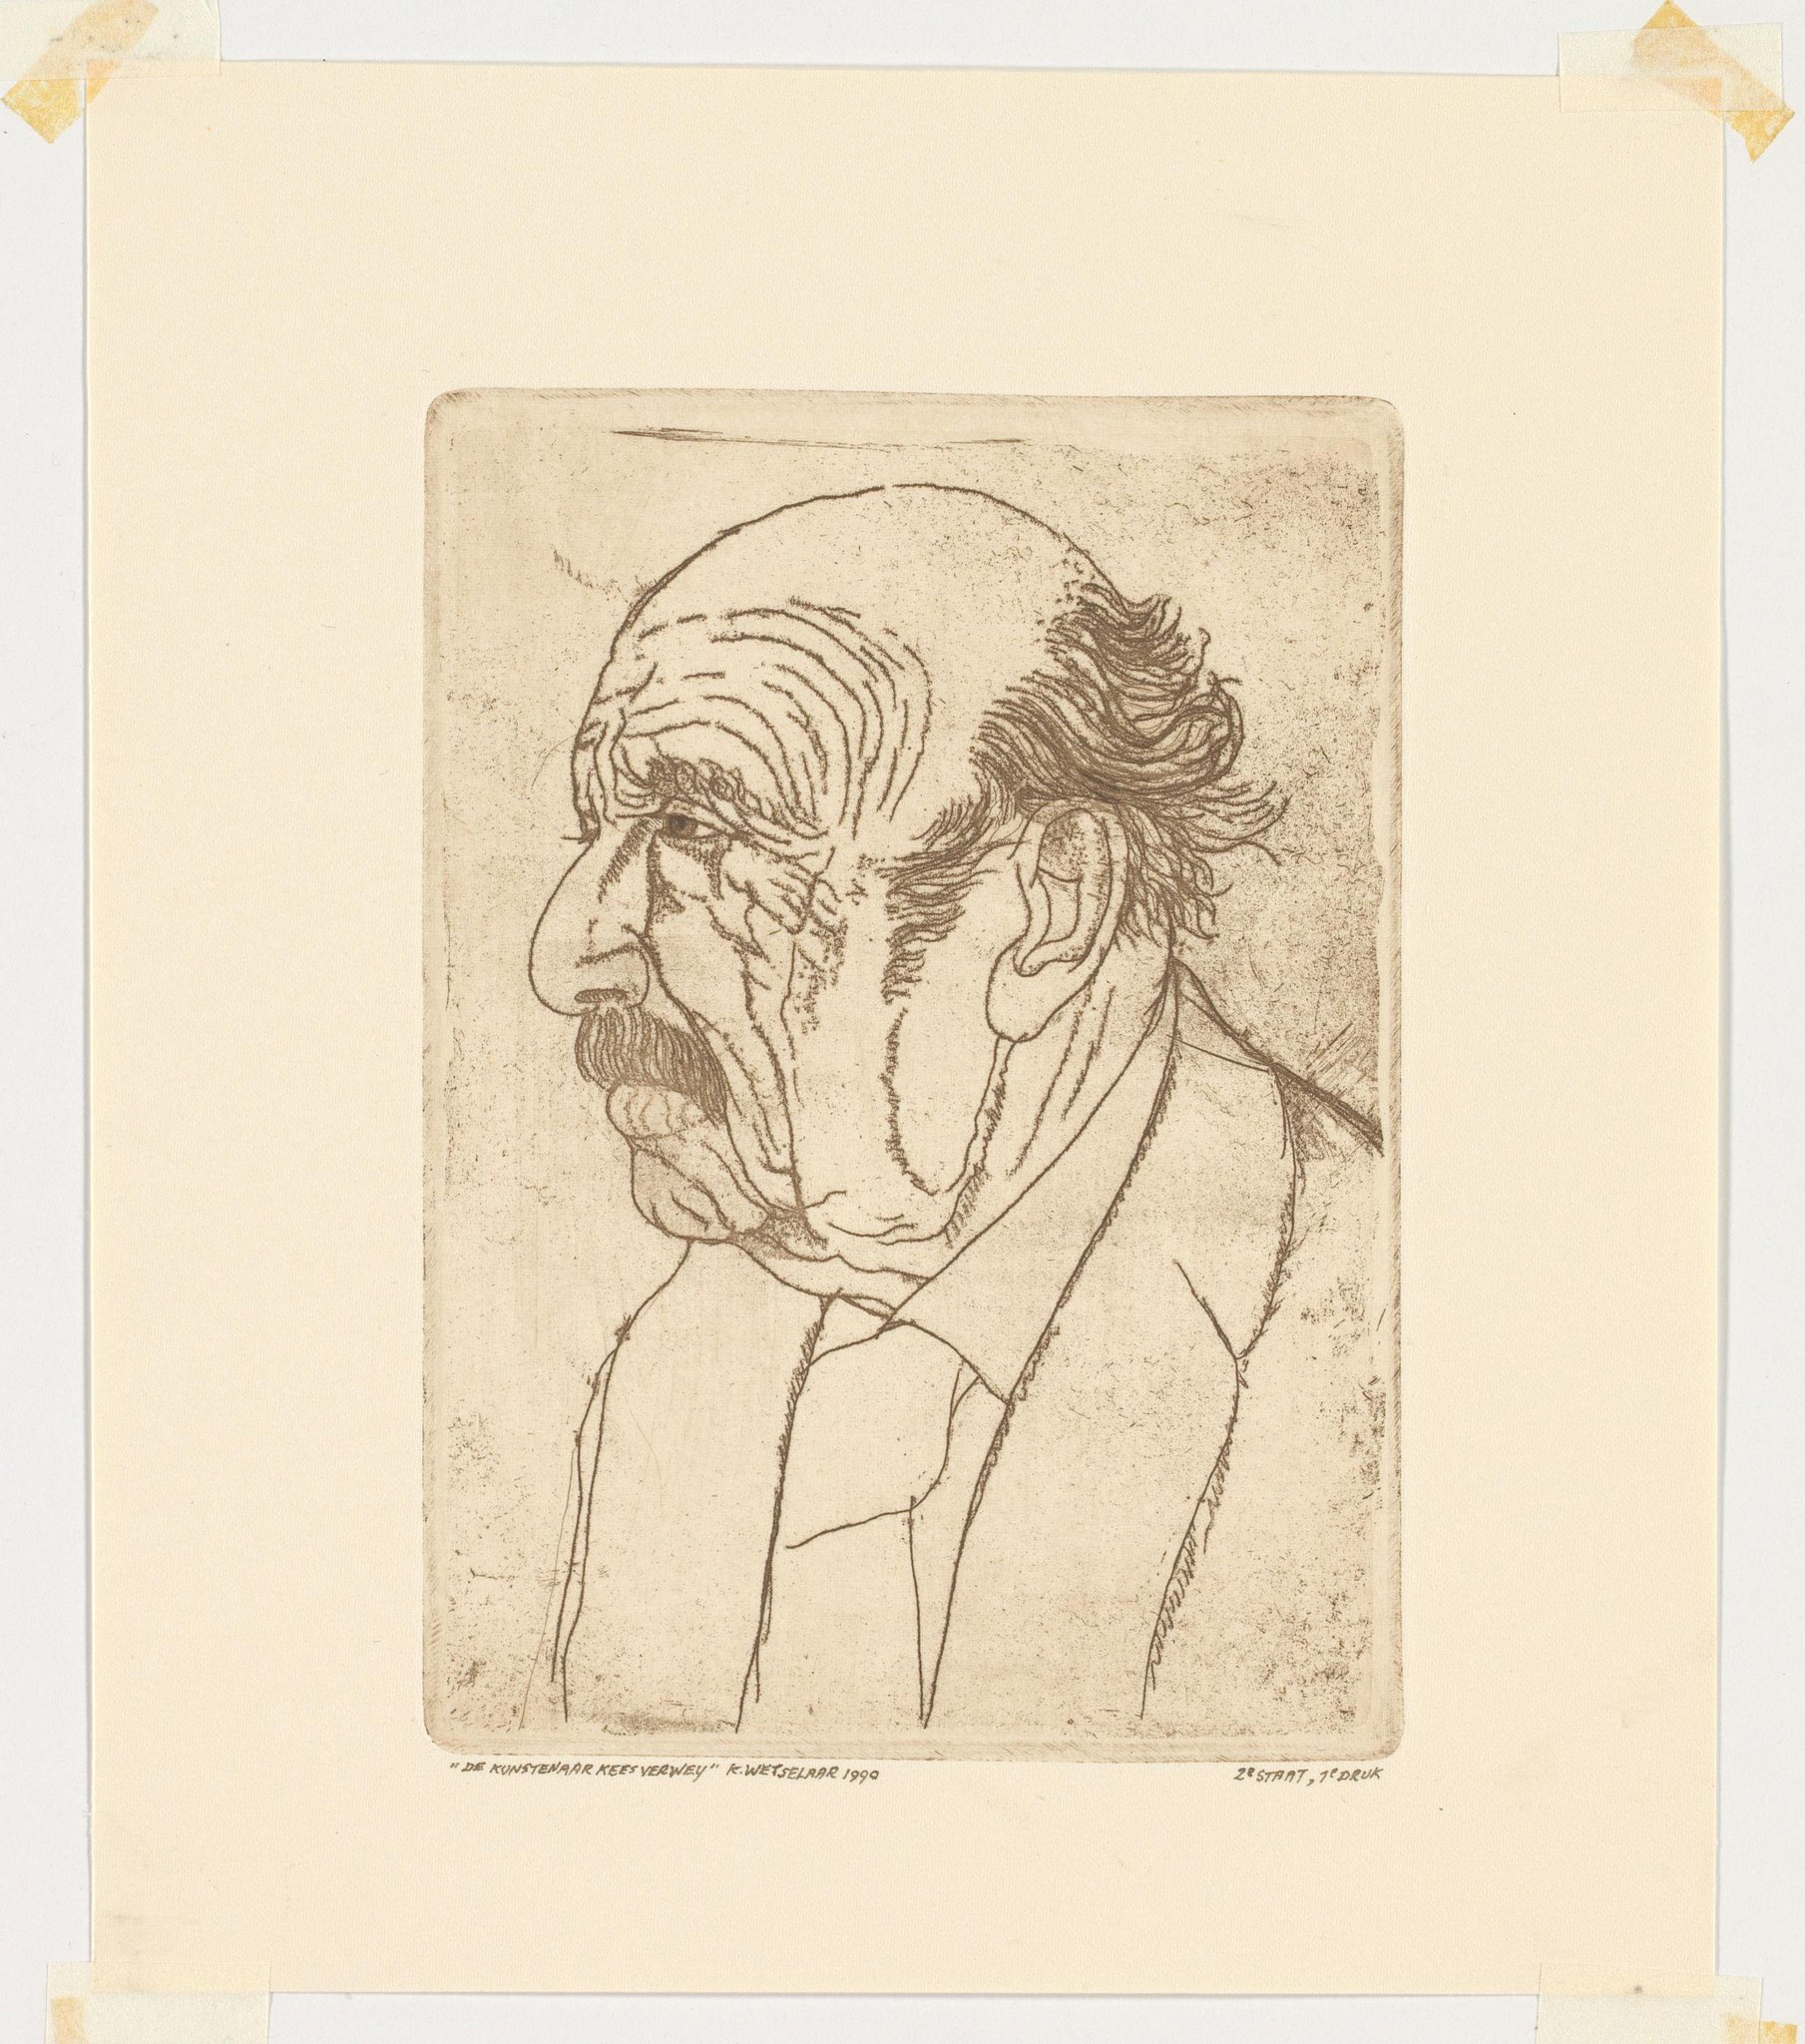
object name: print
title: De Kunstenaar Kees Verwey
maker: karel wetselaar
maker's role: print maker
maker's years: 1935-2017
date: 1990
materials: paper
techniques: drypoint, etching, soft ground etching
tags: amsterdam, print maker, draughtsman, kees verwey, historical persons, portrait, self-portrait of artist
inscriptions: signature and date: ‘K. Wetselaar 1990’, inscription: ‘2e staat, 1e druk’